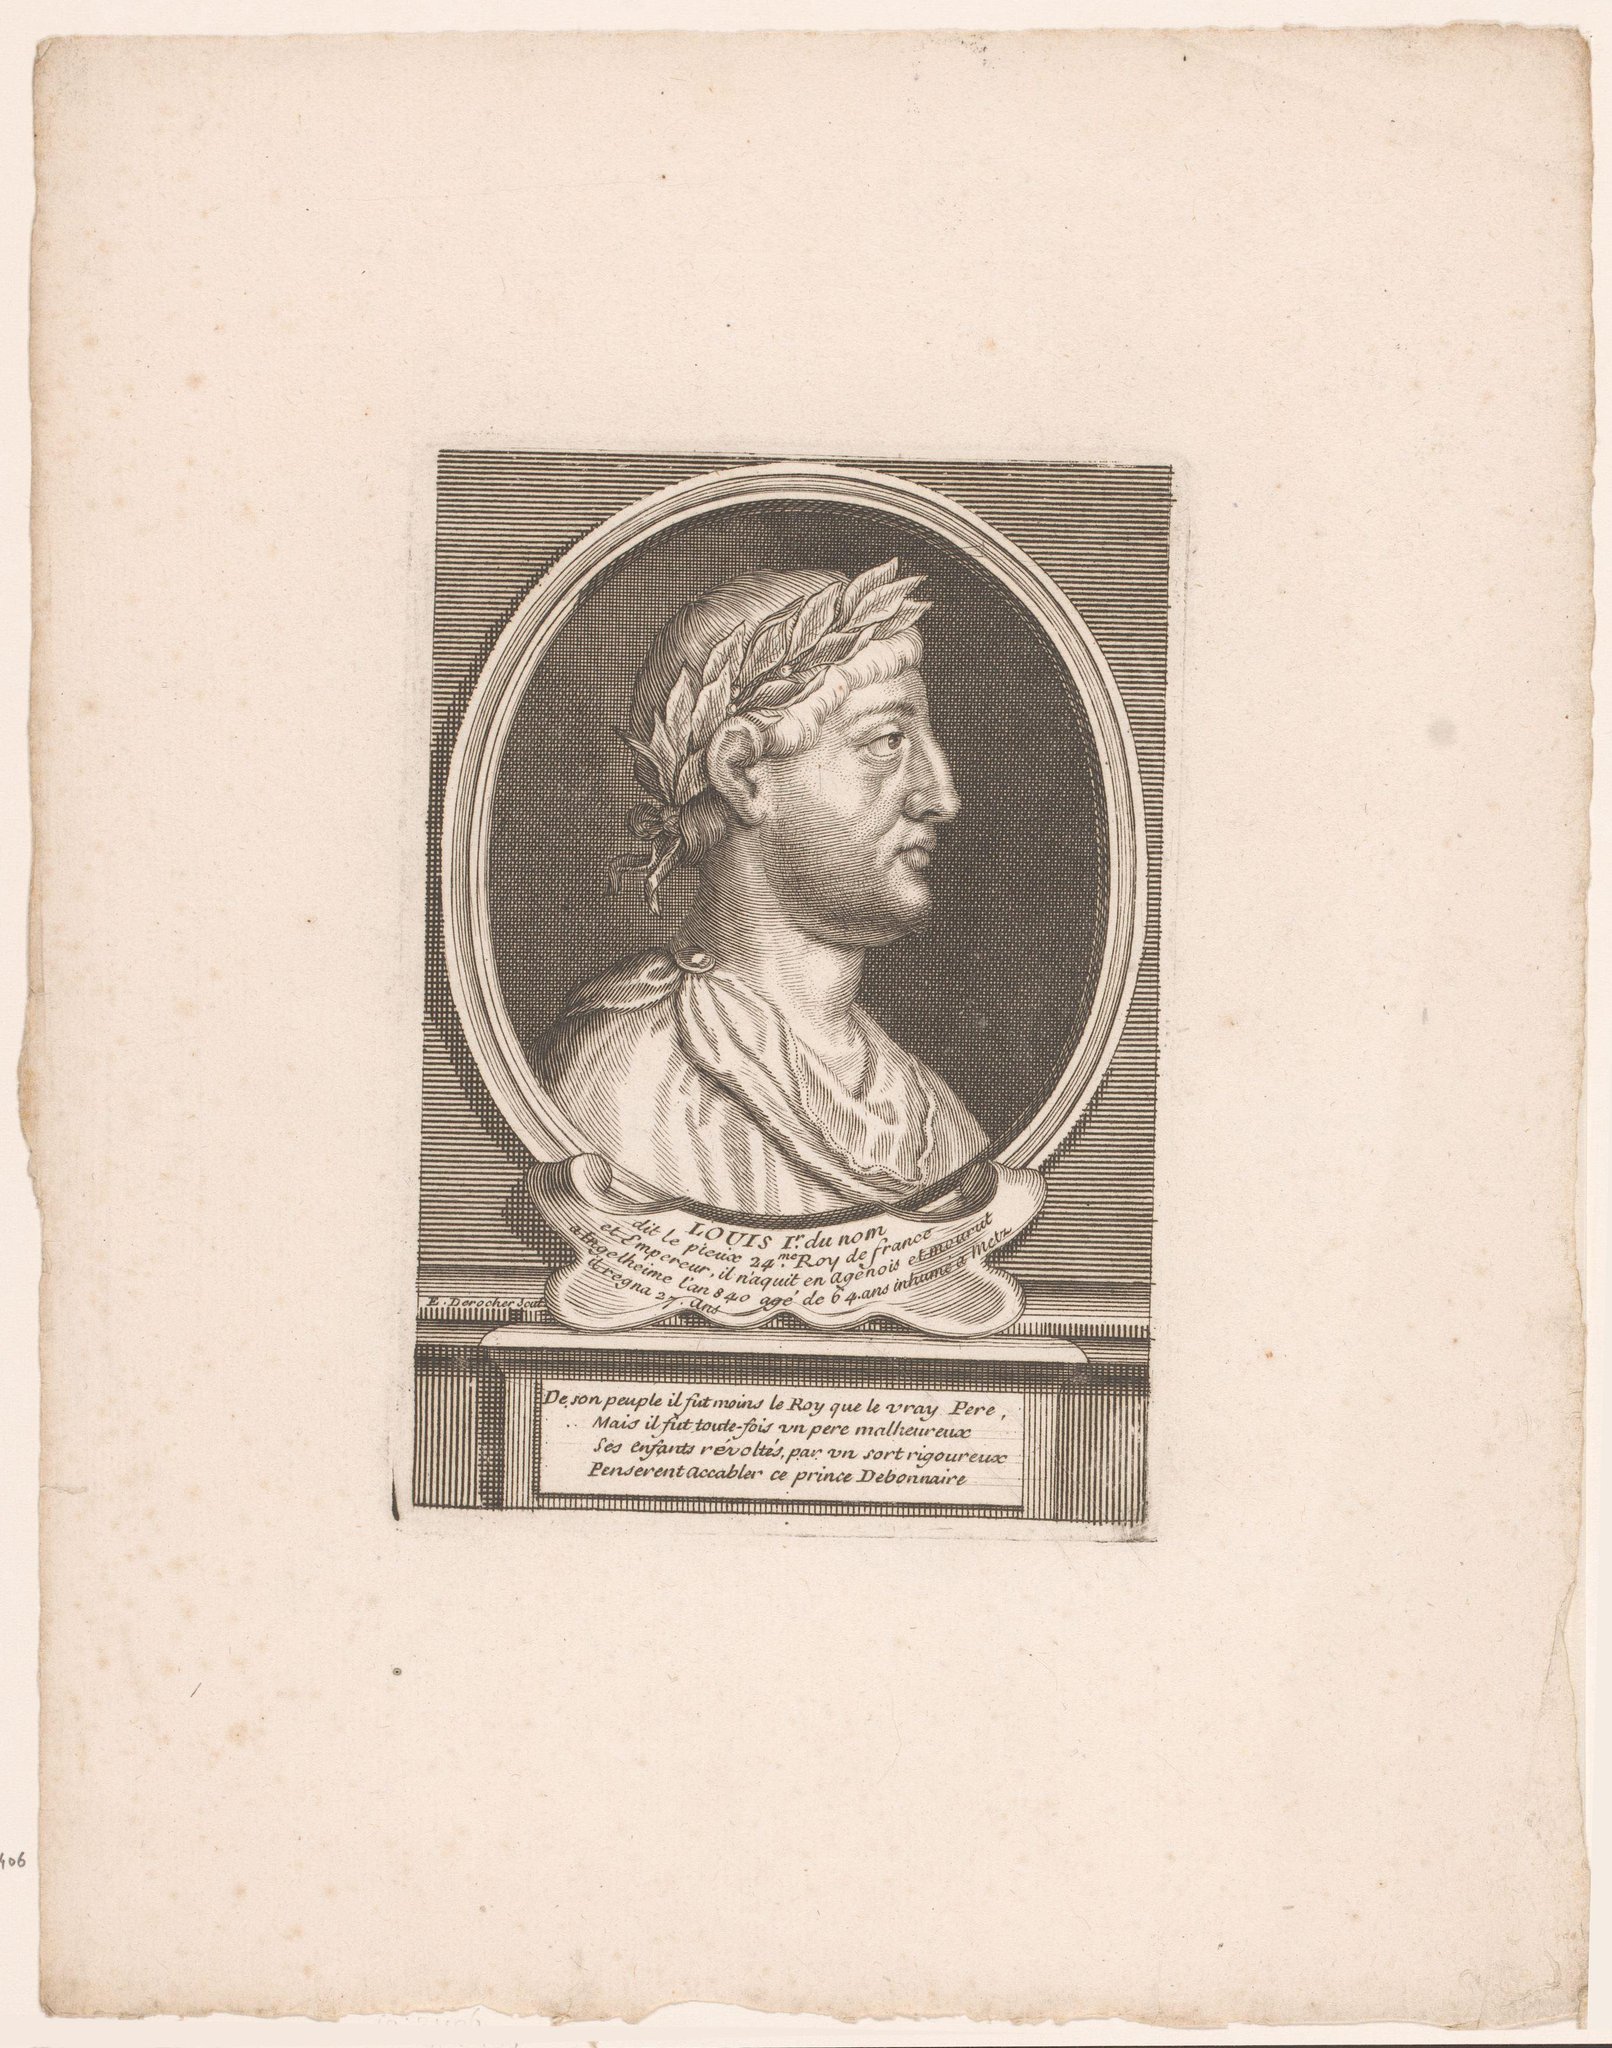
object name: print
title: Recueil de portraits (...)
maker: étienne desrochers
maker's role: print maker, publisher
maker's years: 1668-1741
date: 1726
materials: paper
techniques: engraving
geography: paris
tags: france, historical persons, king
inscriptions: collector's mark: Lugt 2228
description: Behoort waarschijnlijk tot een serie portretten, grotendeels door Etienne Desrochers, getiteld: 'Recueil de portraits de personnes qui se sont distinguées tant dans les Armes que dans Belles-Lettres et les Arts, comme aussi la famille royale de France et autres cours étrangères'. De serie werd initieel uitgegeven door Desrochers en aangekondigd in 'Mercure' in mei 1726, p. 985. Echter was Desrochers reeds enkele jaren eerder begonnen met het uitgeven van de serie. Na de dood van Desrochers werd de serie voortgezet door Gilles Edme Petit. Een latere staat werd uitgegeven door Jean François Daumont in Parijs.